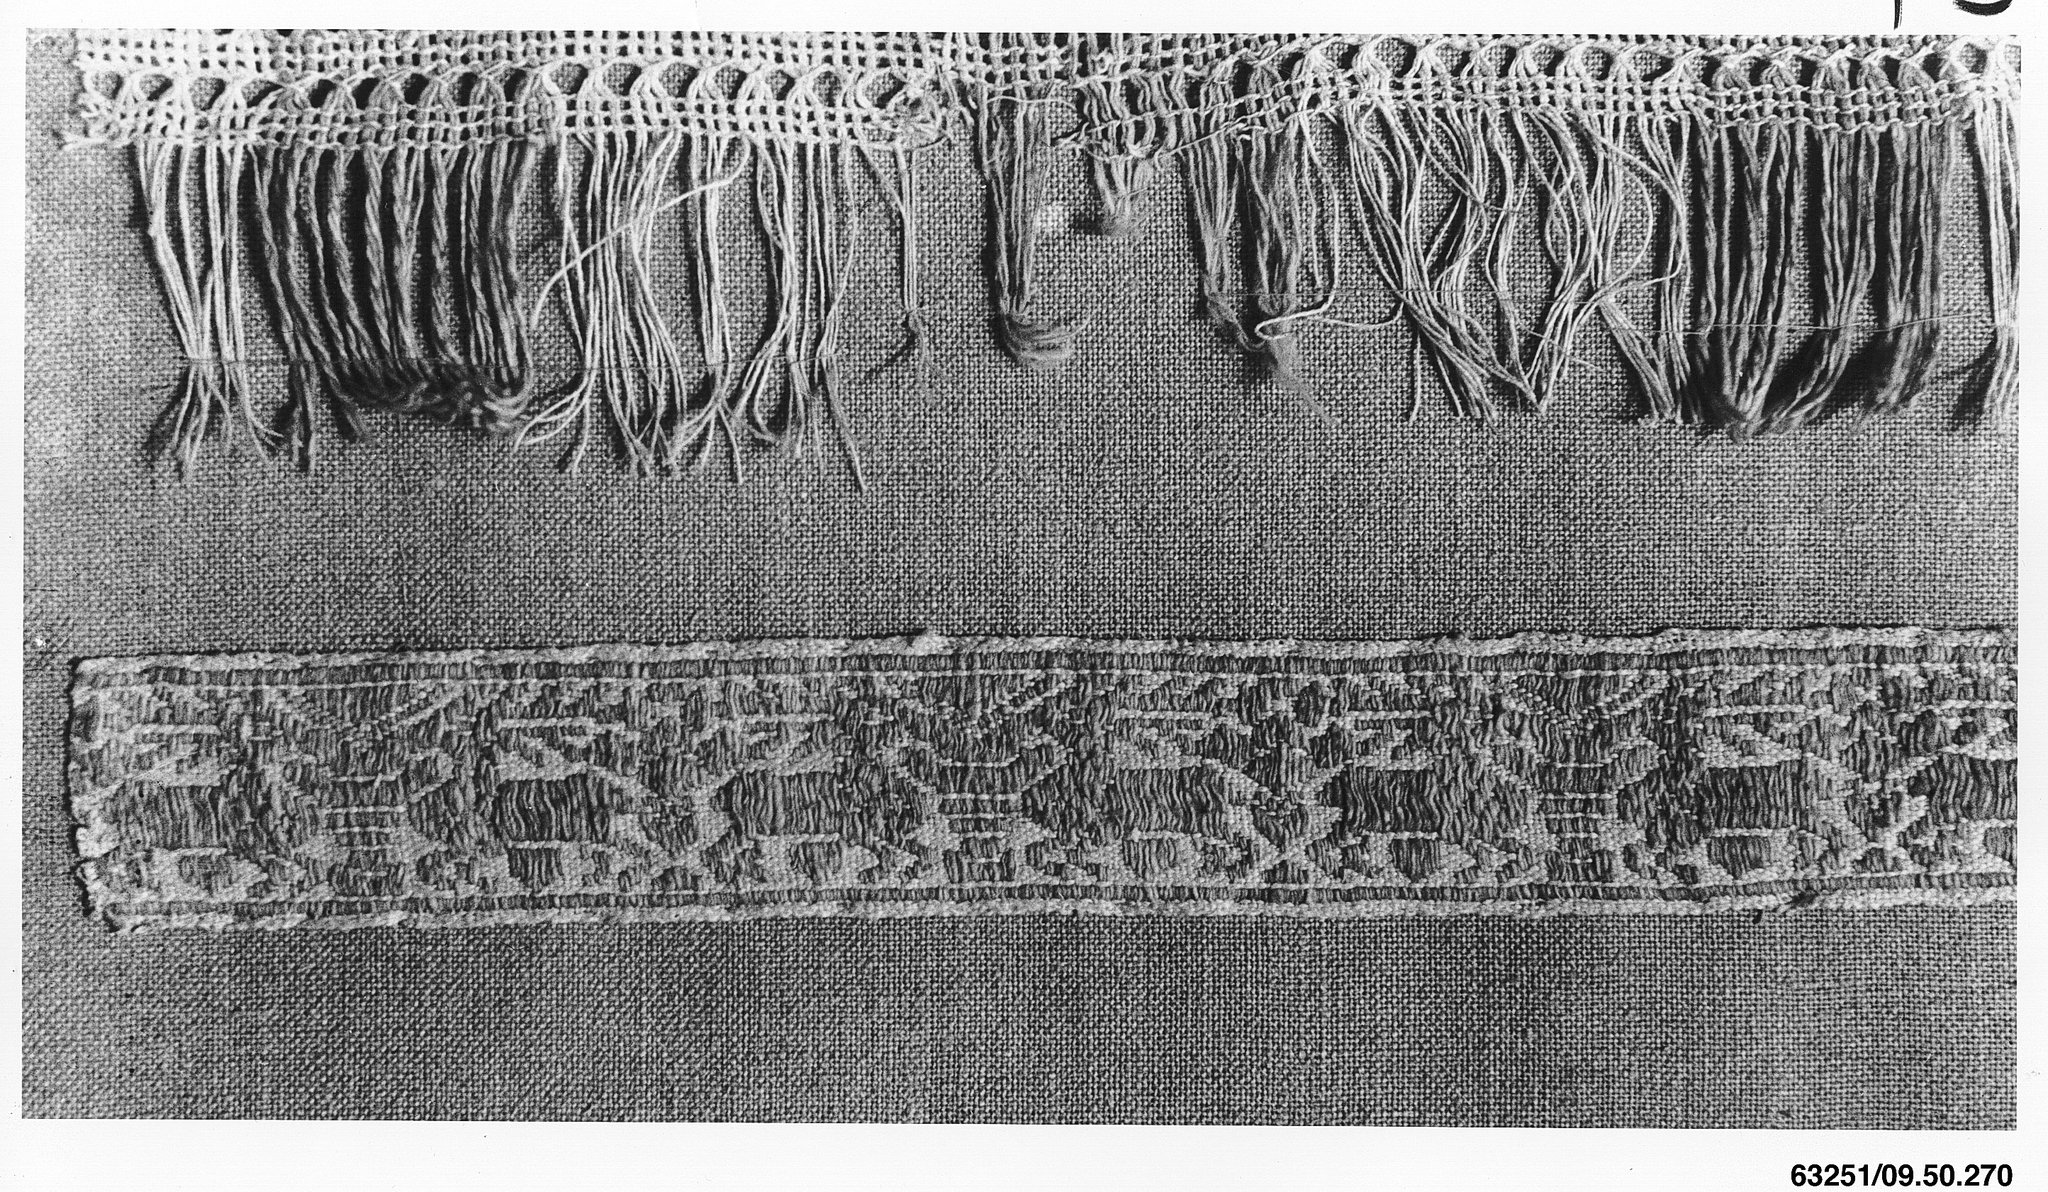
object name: band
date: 1701-1900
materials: cotton, linen